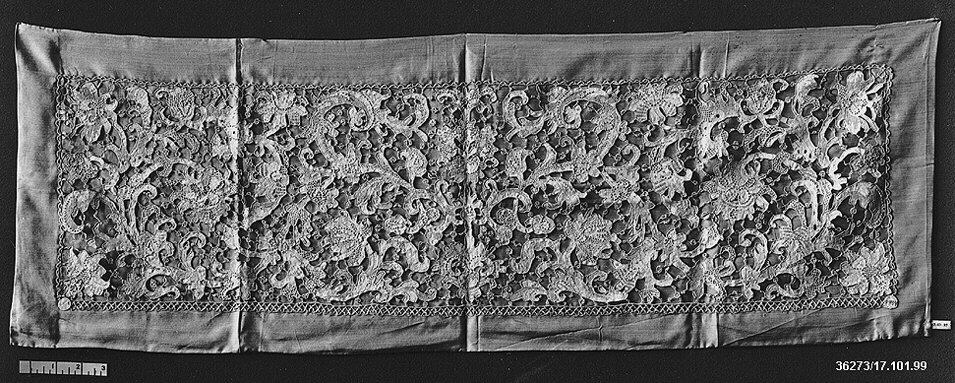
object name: panel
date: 1701-1800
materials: lace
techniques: gros point, lace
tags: flowers,leaves